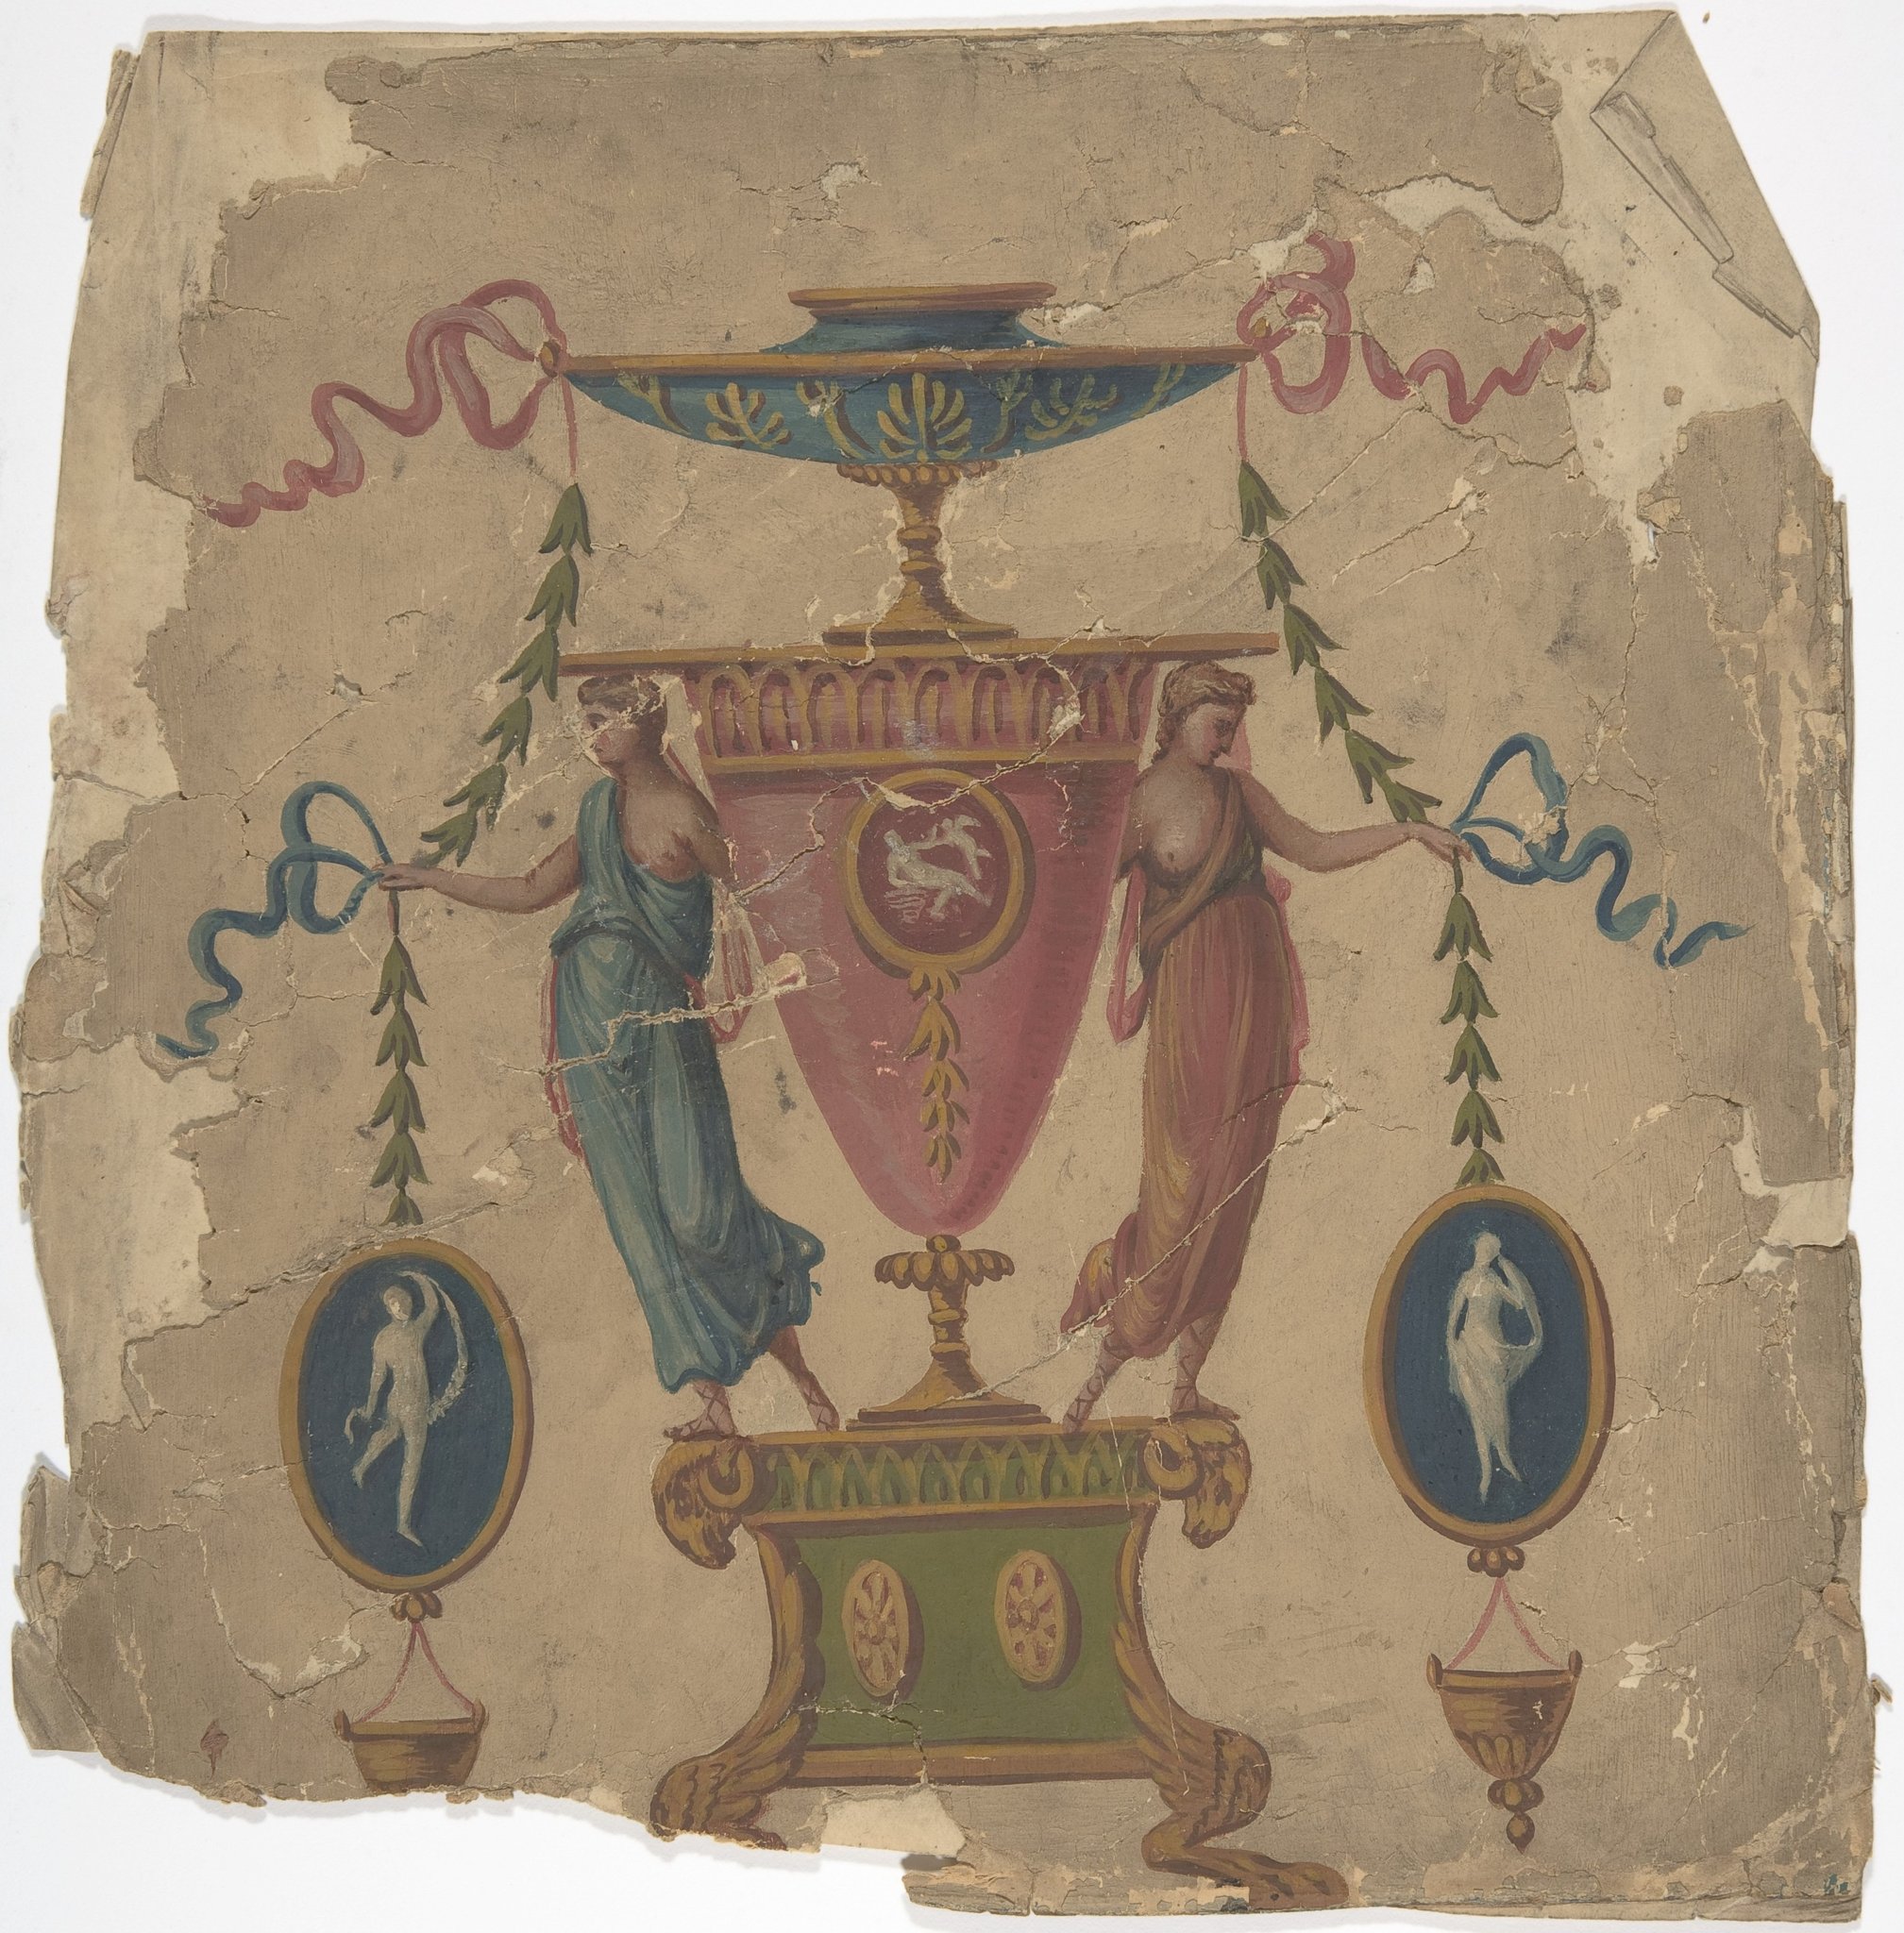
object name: drawing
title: Ornamental Panel Design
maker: anonymous, british, 19th century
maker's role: artist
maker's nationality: british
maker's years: 1800-1900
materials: gouache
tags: men,women